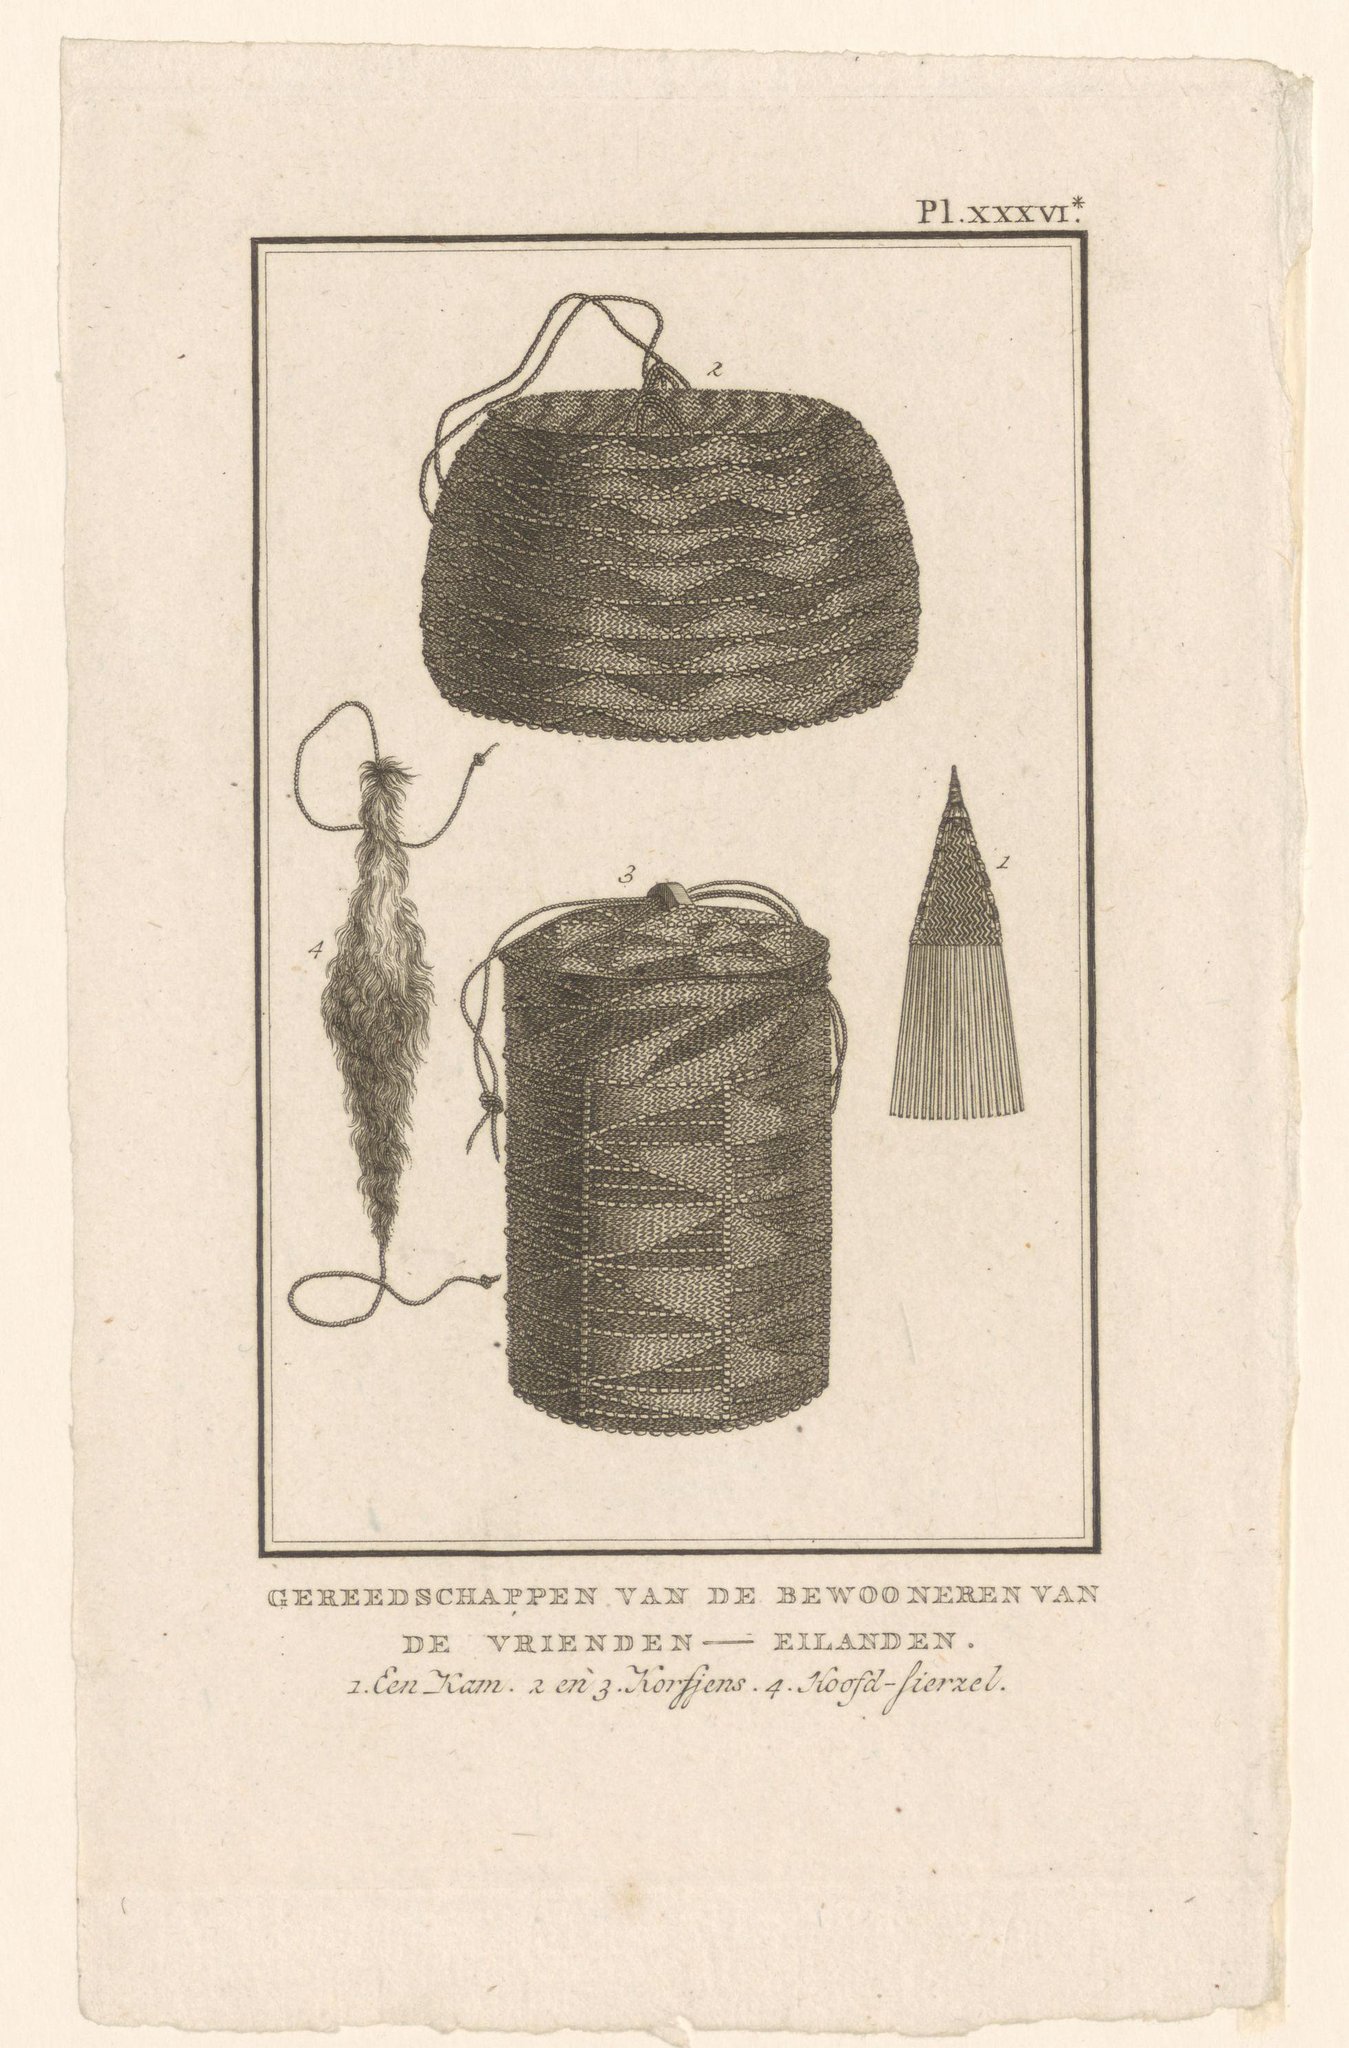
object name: book illustration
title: Wapens en panfluit gemaakt door de oorspronkelijke bewoners van Tonga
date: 1795-1803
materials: paper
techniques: engraving, etching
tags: panpipes, helved weapons, polearms (for striking, hacking, thrusting), weapons for striking a blow, archer's weapons: arrow, casting weapons: spear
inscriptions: number: ‘XXXVII’, collector's mark: Lugt 2228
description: De prent is gebruikt in: Cook, James. Reize rondom de Waereld (...) met kaarten en plaaten. [Vertaald uit het Engels door] Jan David Pasteur. Leiden: Honkoop, Amsterdam: Allart, Den Haag: Van Cleef, 1795-1803, dl. 13.